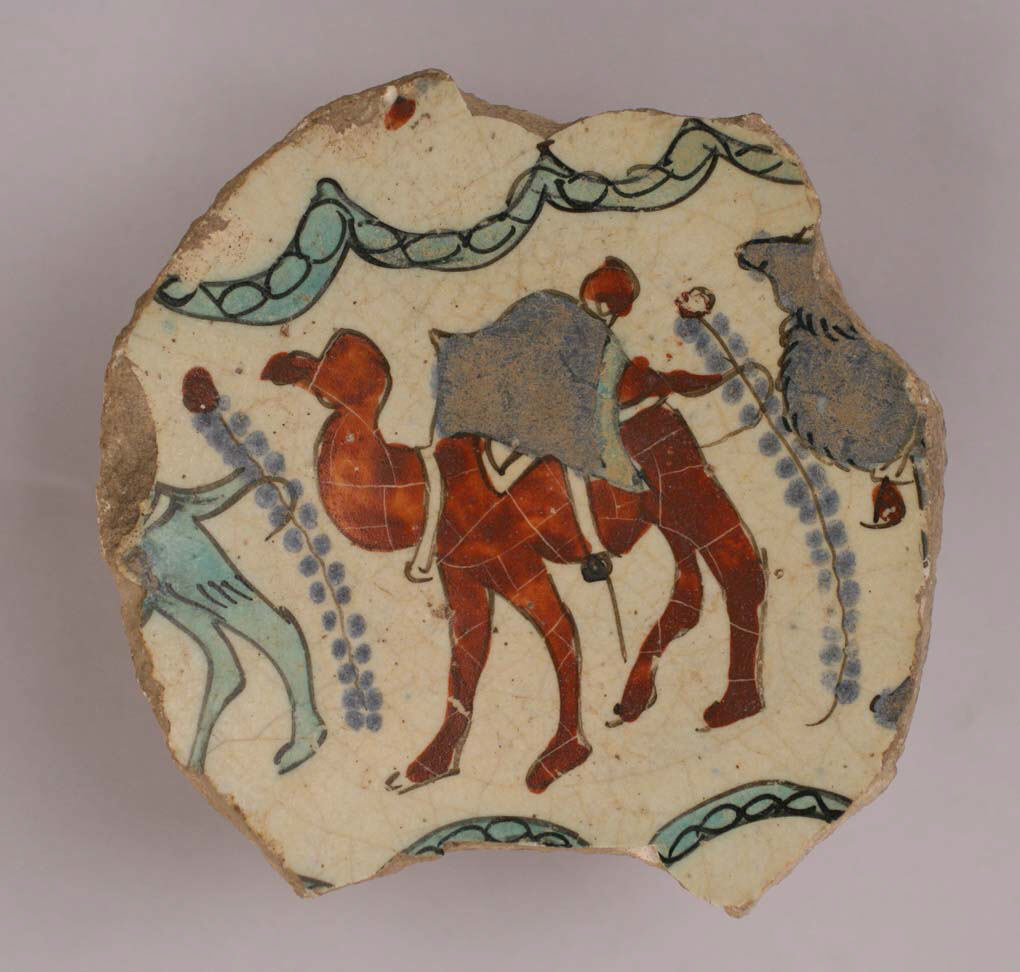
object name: fragment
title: Fragment of a Bowl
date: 1101-1300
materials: stonepaste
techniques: overglaze, painting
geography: iran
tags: camels